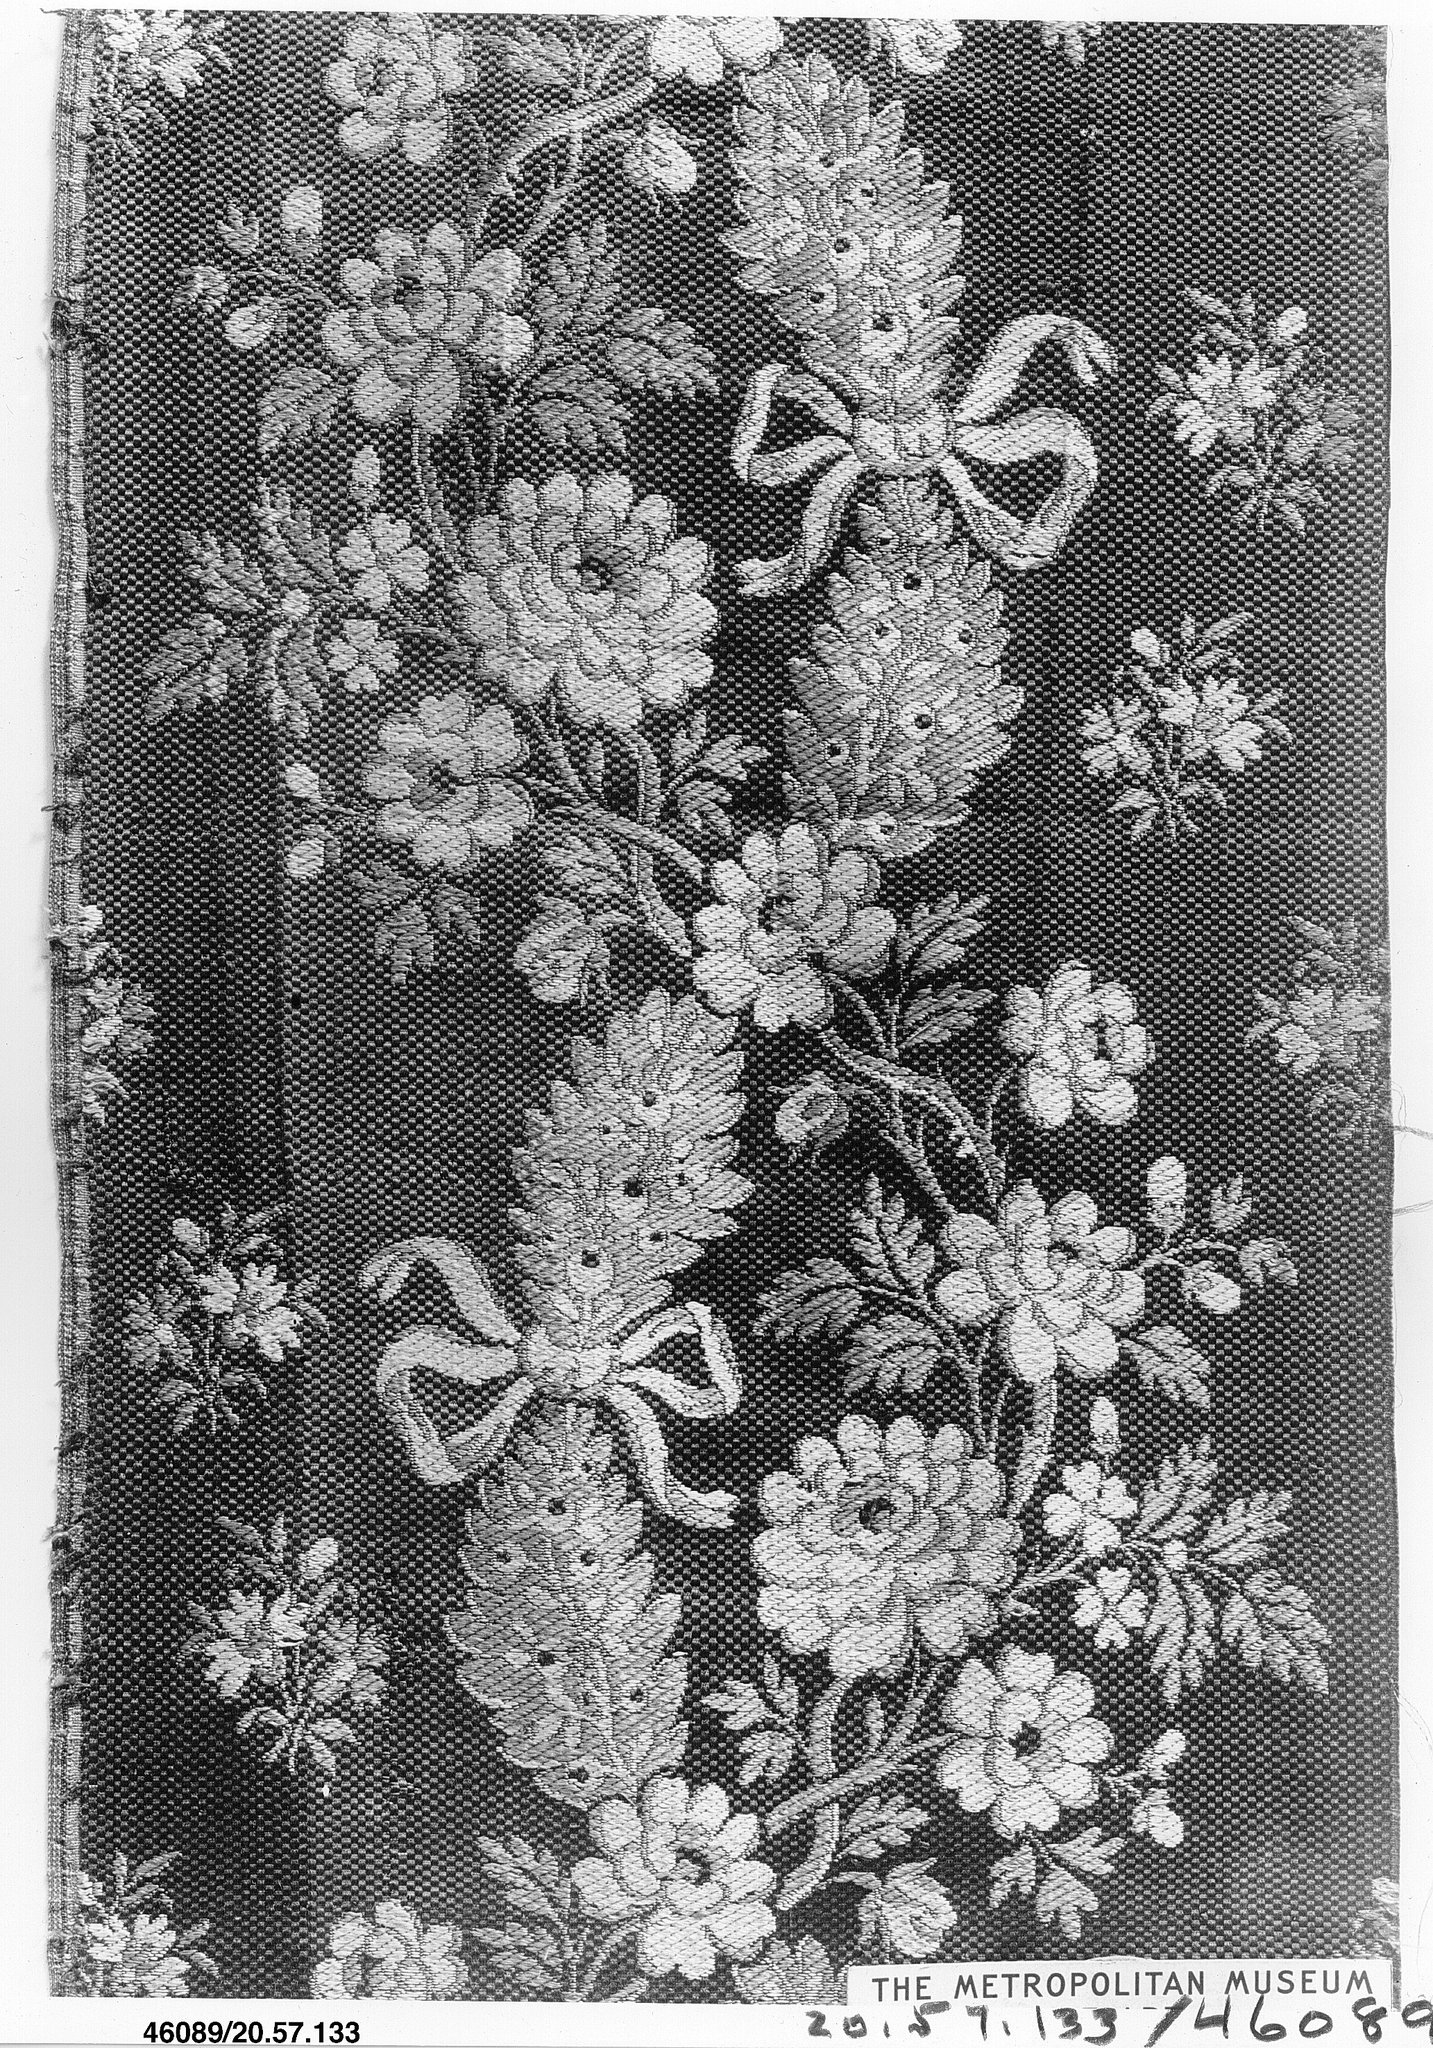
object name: piece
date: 1750-1760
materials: silk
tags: flowers,leaves